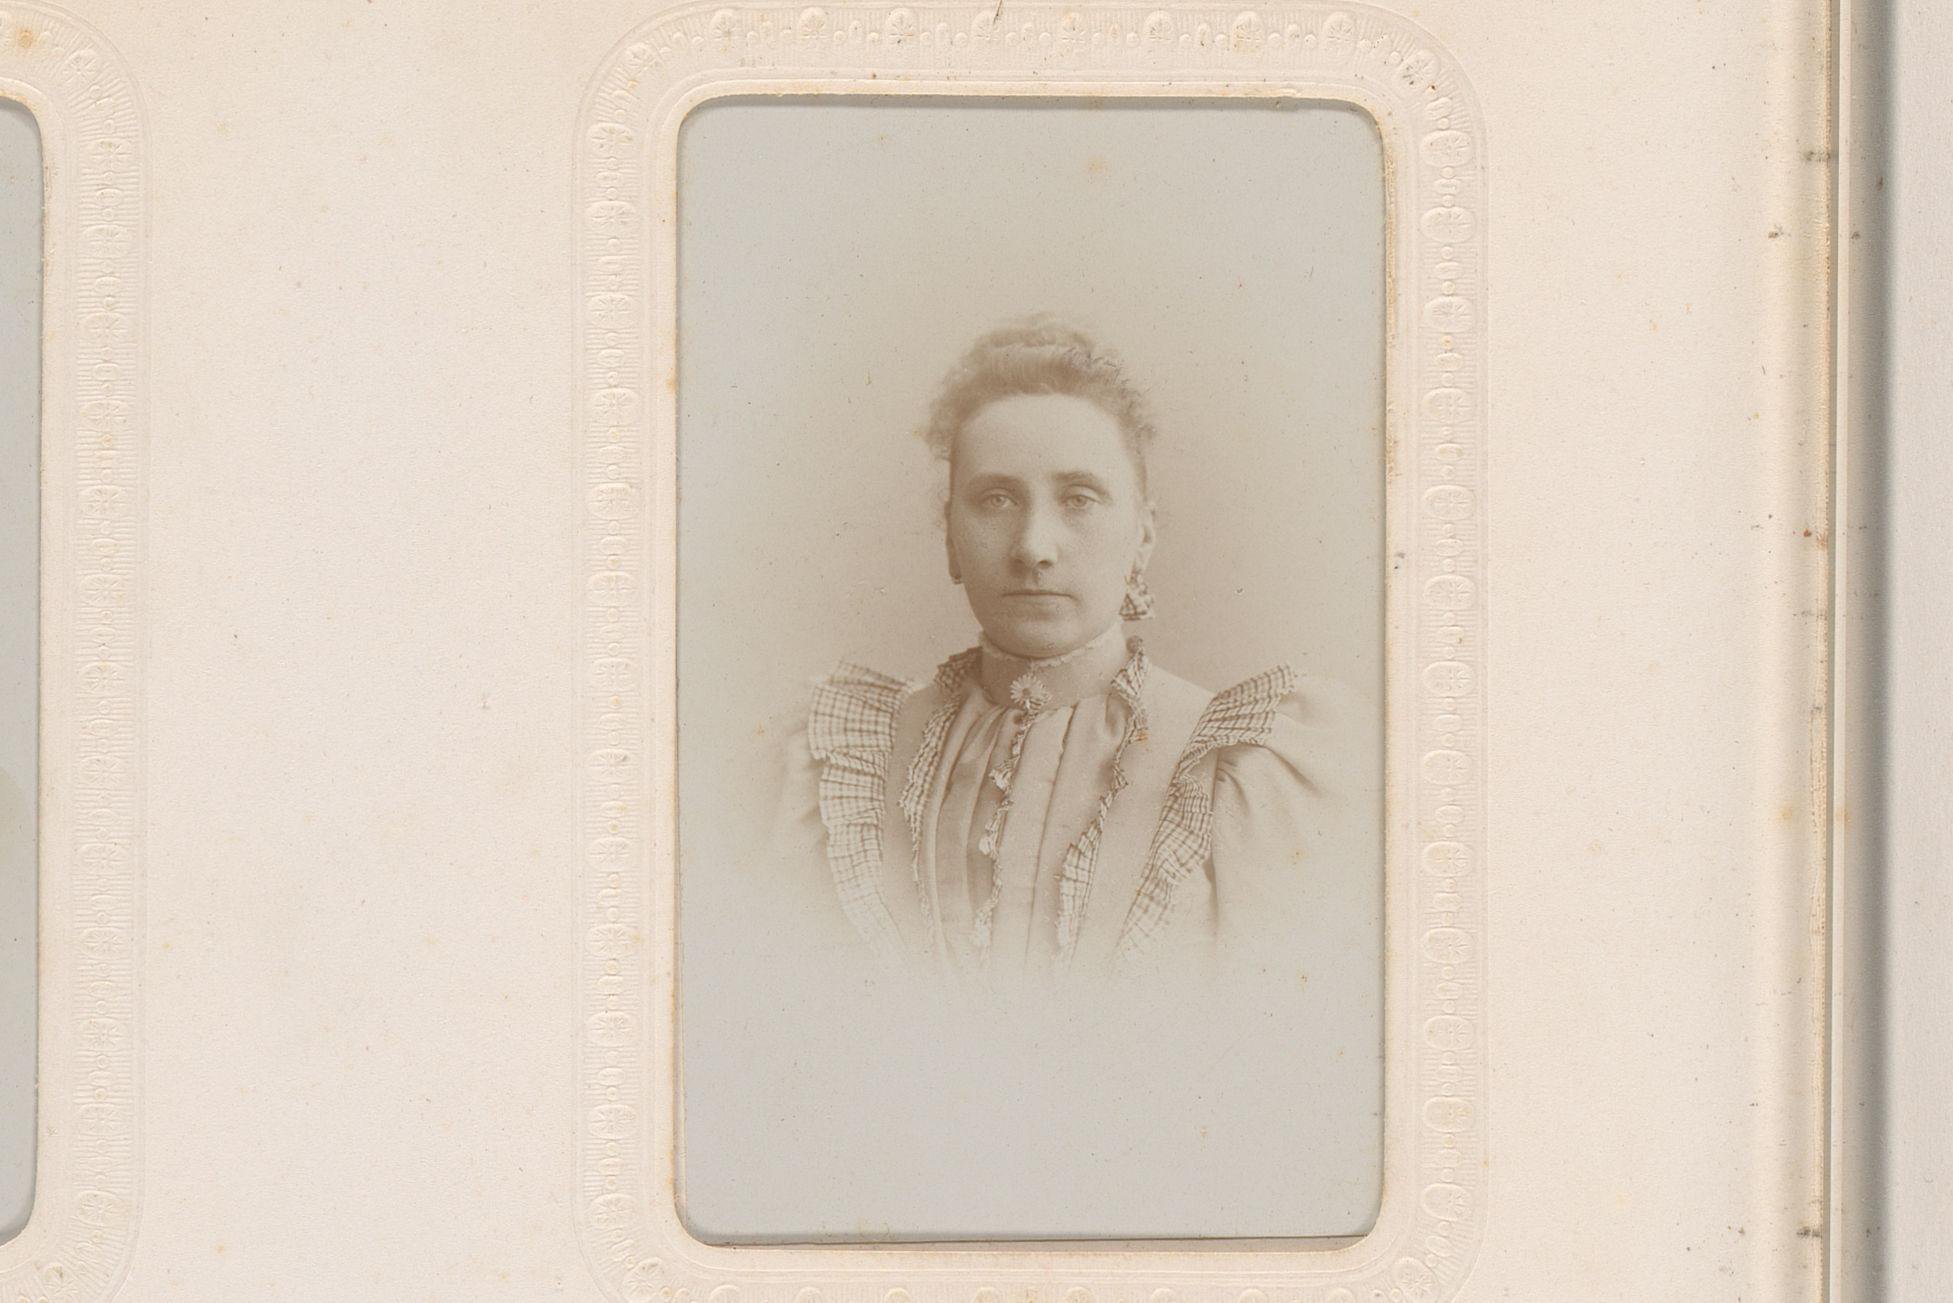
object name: photograph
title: Portret van een vrouw in hooggesloten jurk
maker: Anonymous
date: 1880-1920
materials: cardboard, photographic support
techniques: collodion silver print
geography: netherlands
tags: historical persons - bb - woman